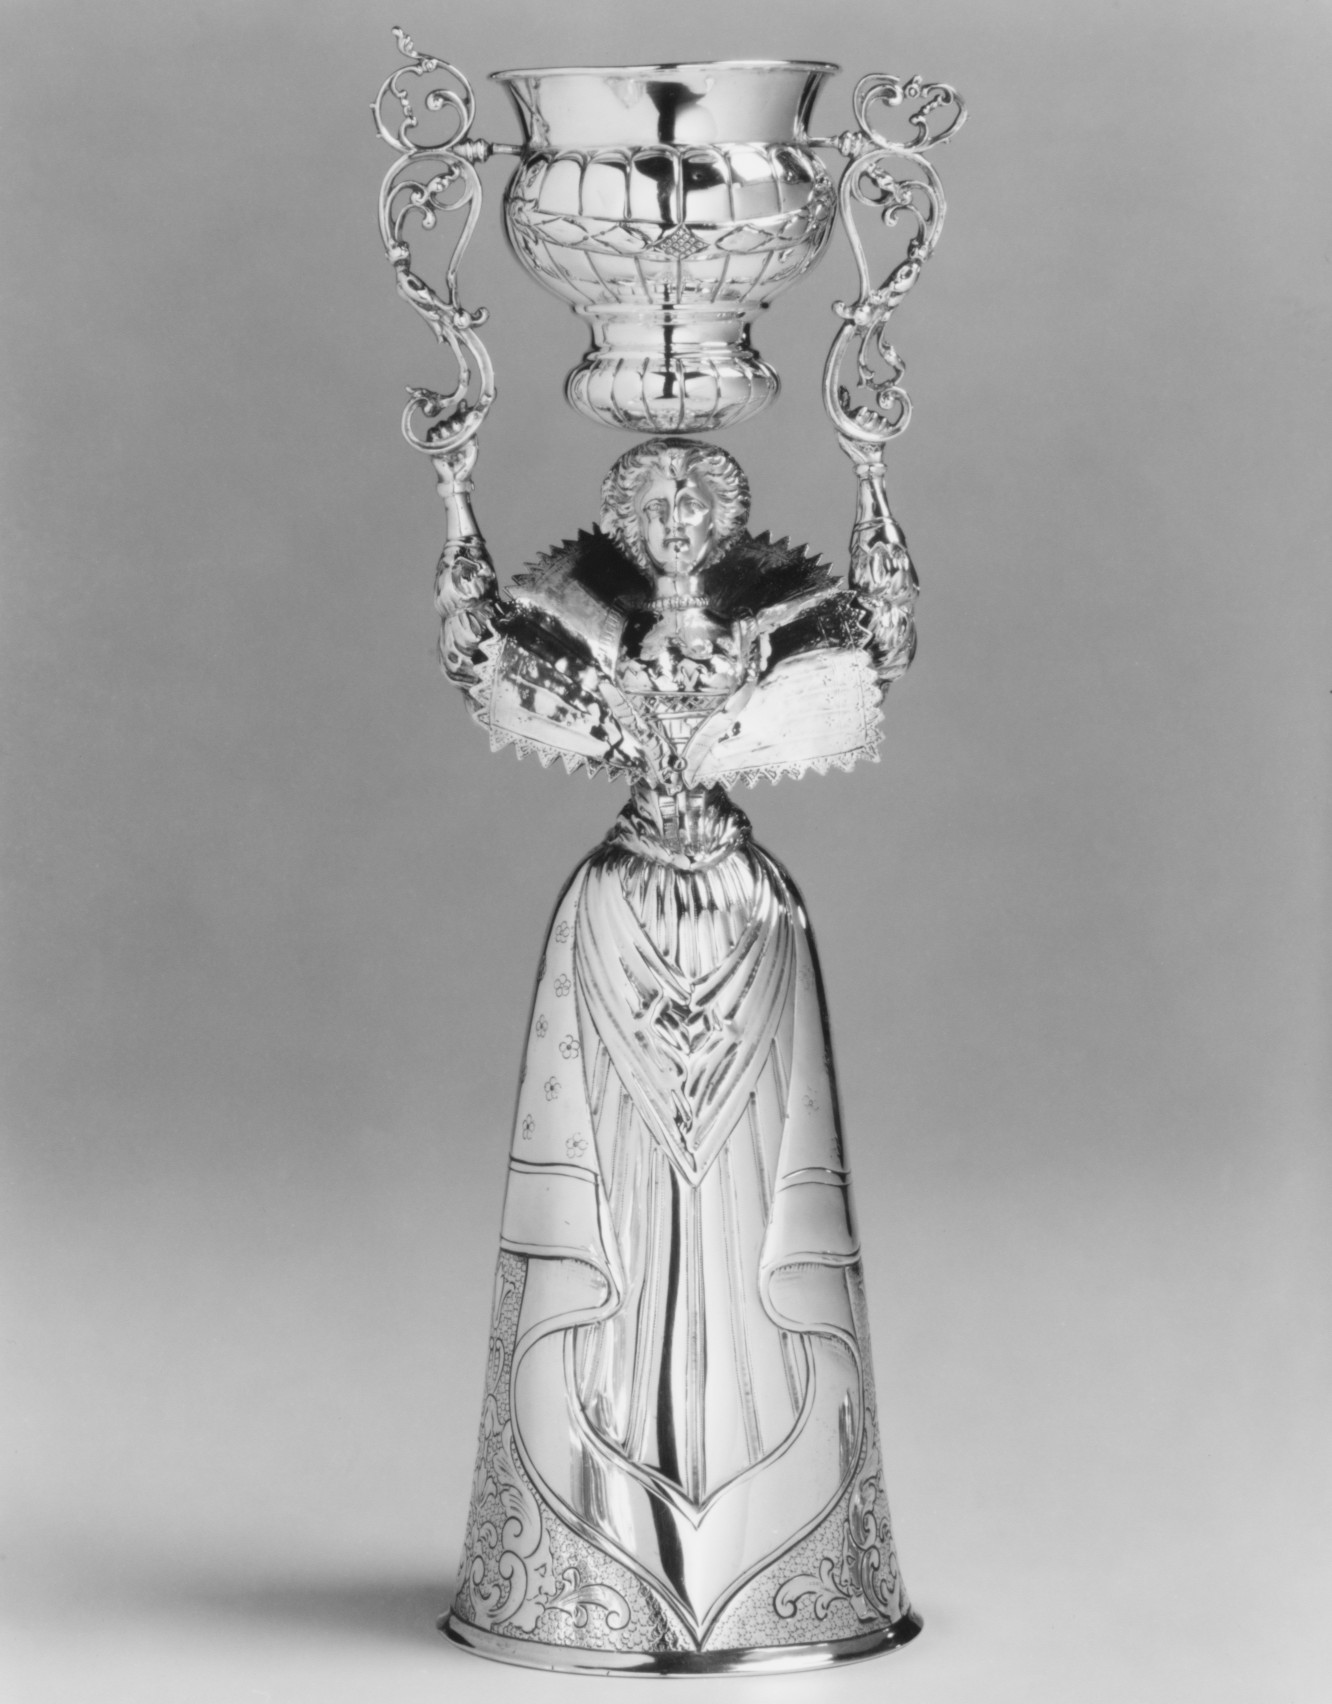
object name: wager cup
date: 1880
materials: silver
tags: women